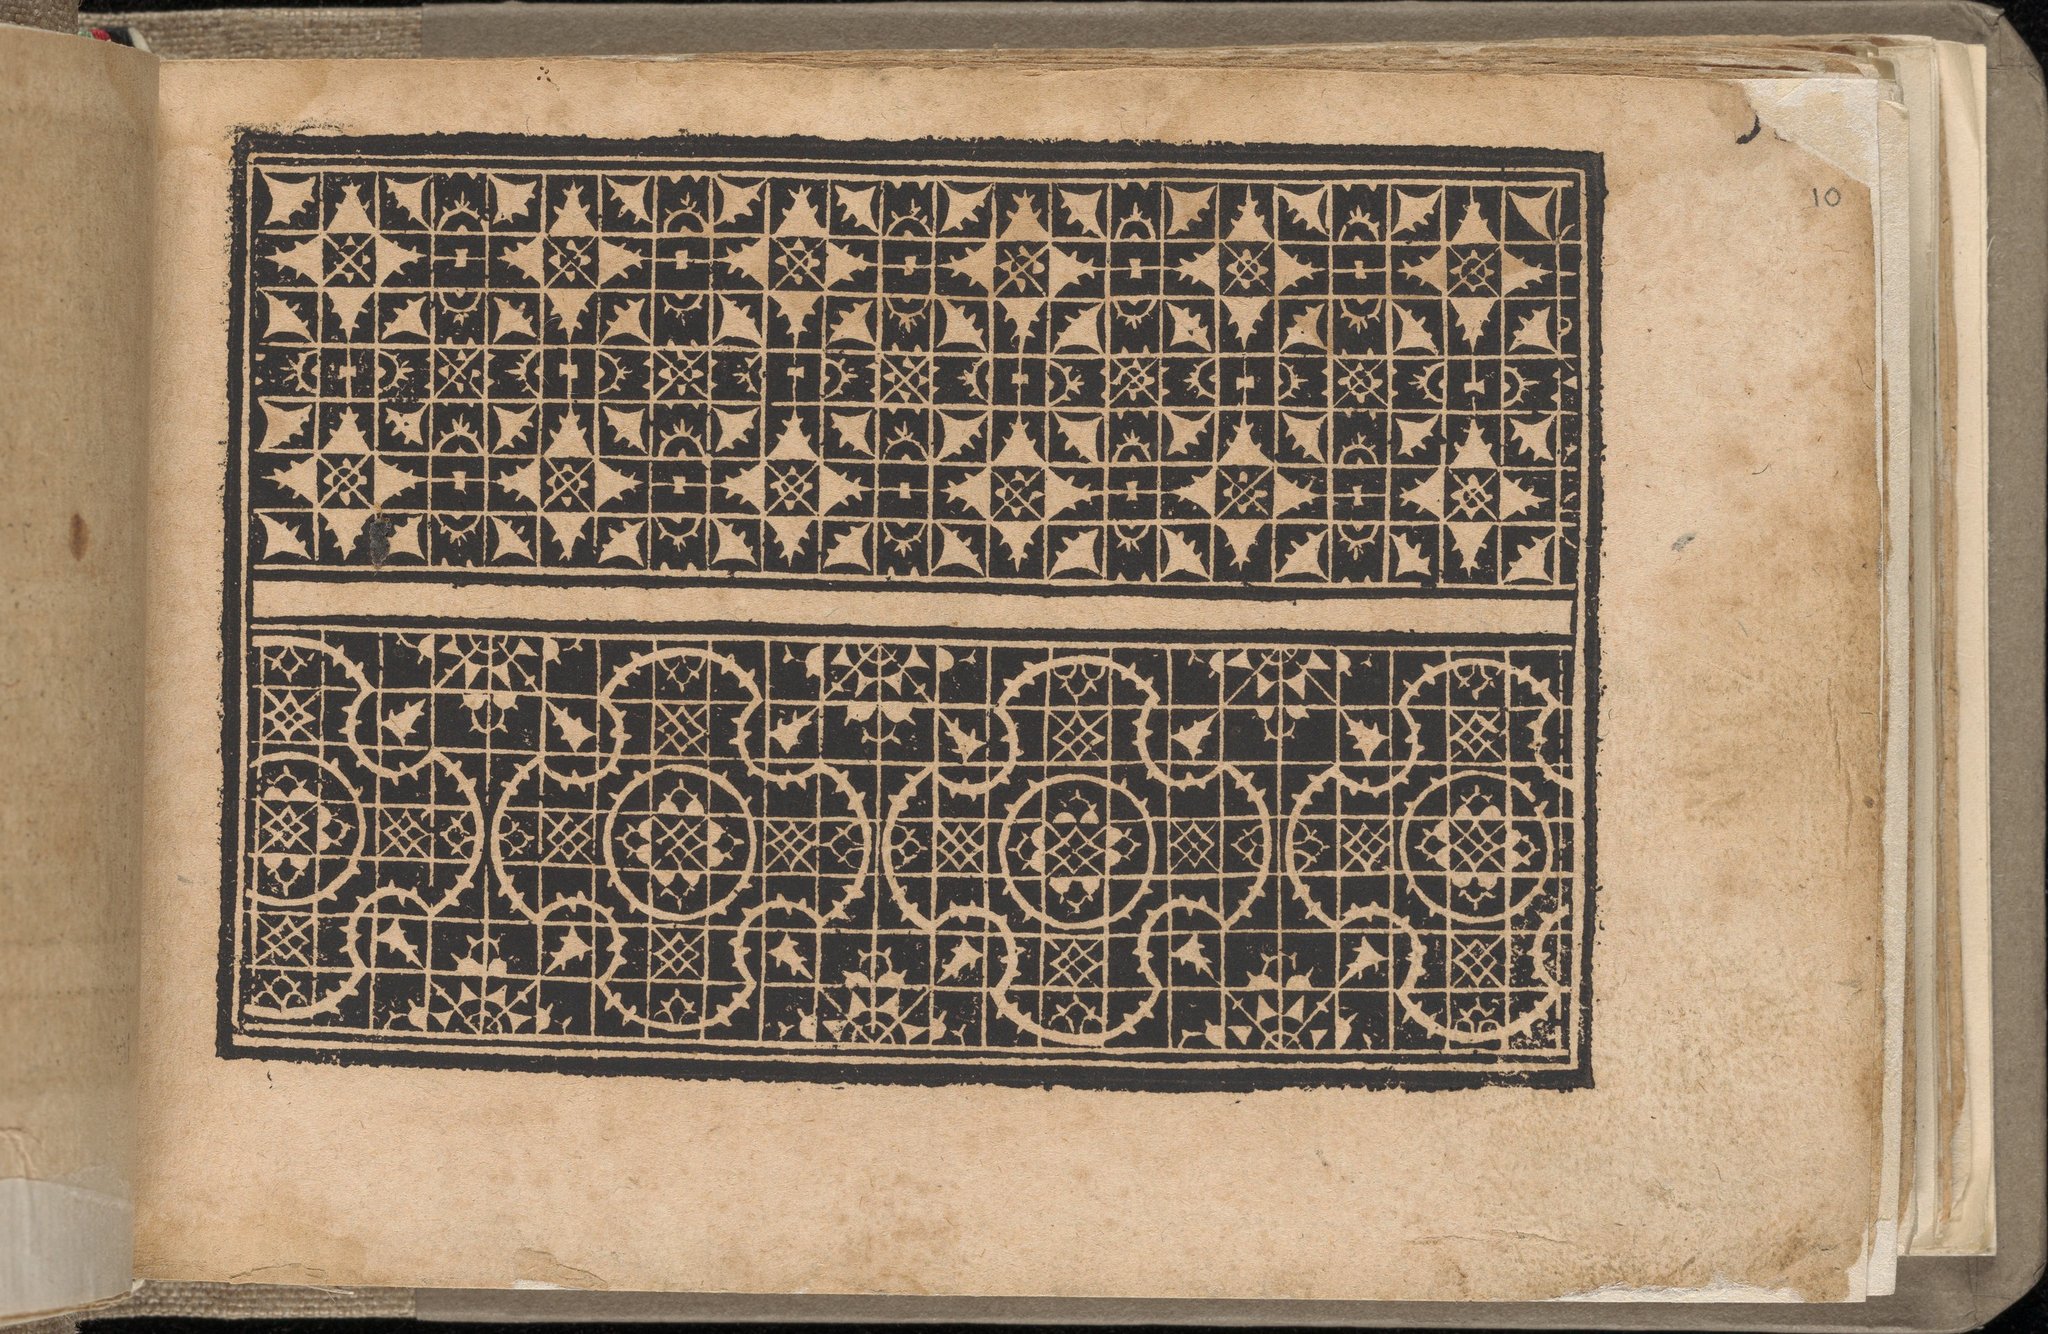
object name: book print ornament architecture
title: Schön newes Modelbuch (Page 10r)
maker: sigismundus latomus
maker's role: publisher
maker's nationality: german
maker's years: 1599-1632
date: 1608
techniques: woodcut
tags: ornament